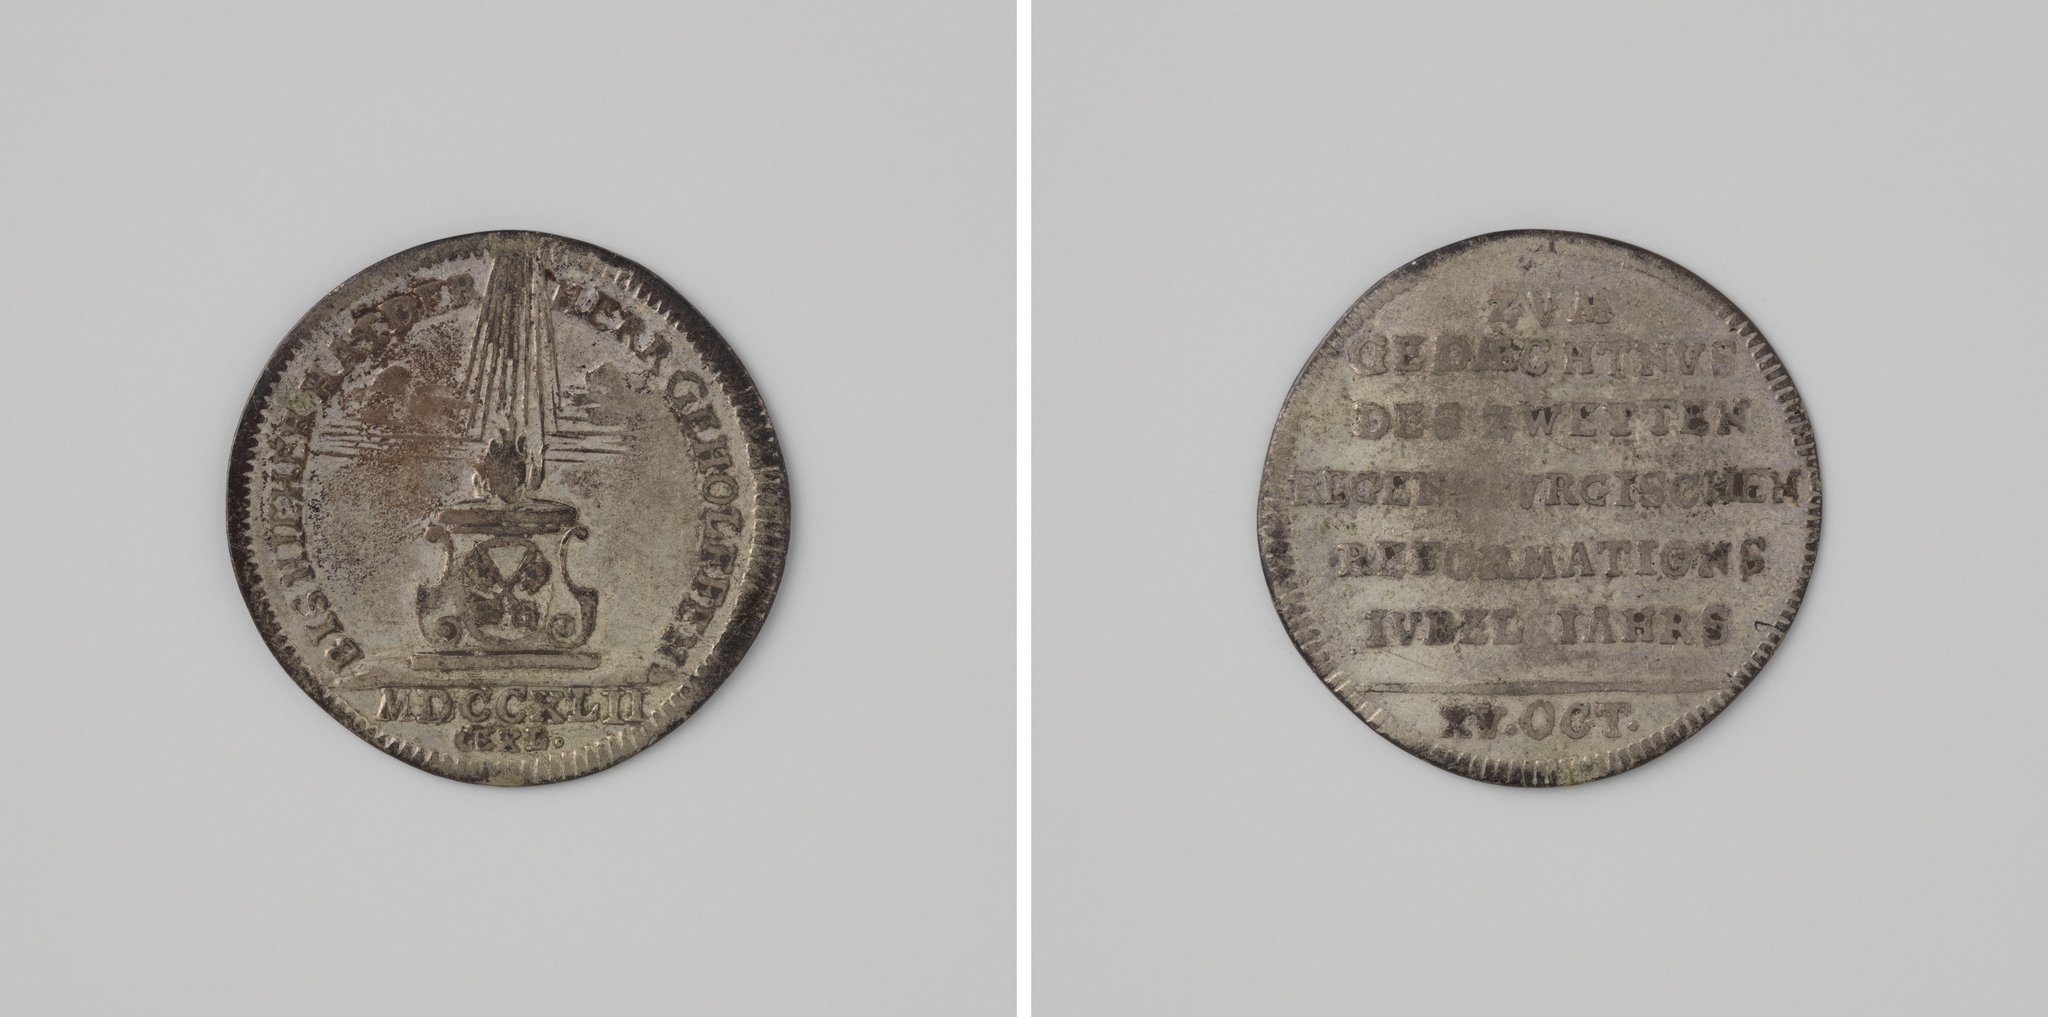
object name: strooipenning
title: Tweede eeuwfeest van de reformatie te Regensburg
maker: christian daniel öxlein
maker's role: mintmaster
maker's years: 1712-1759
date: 1742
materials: silver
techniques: striking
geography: regensburg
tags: regensburg, reformatie